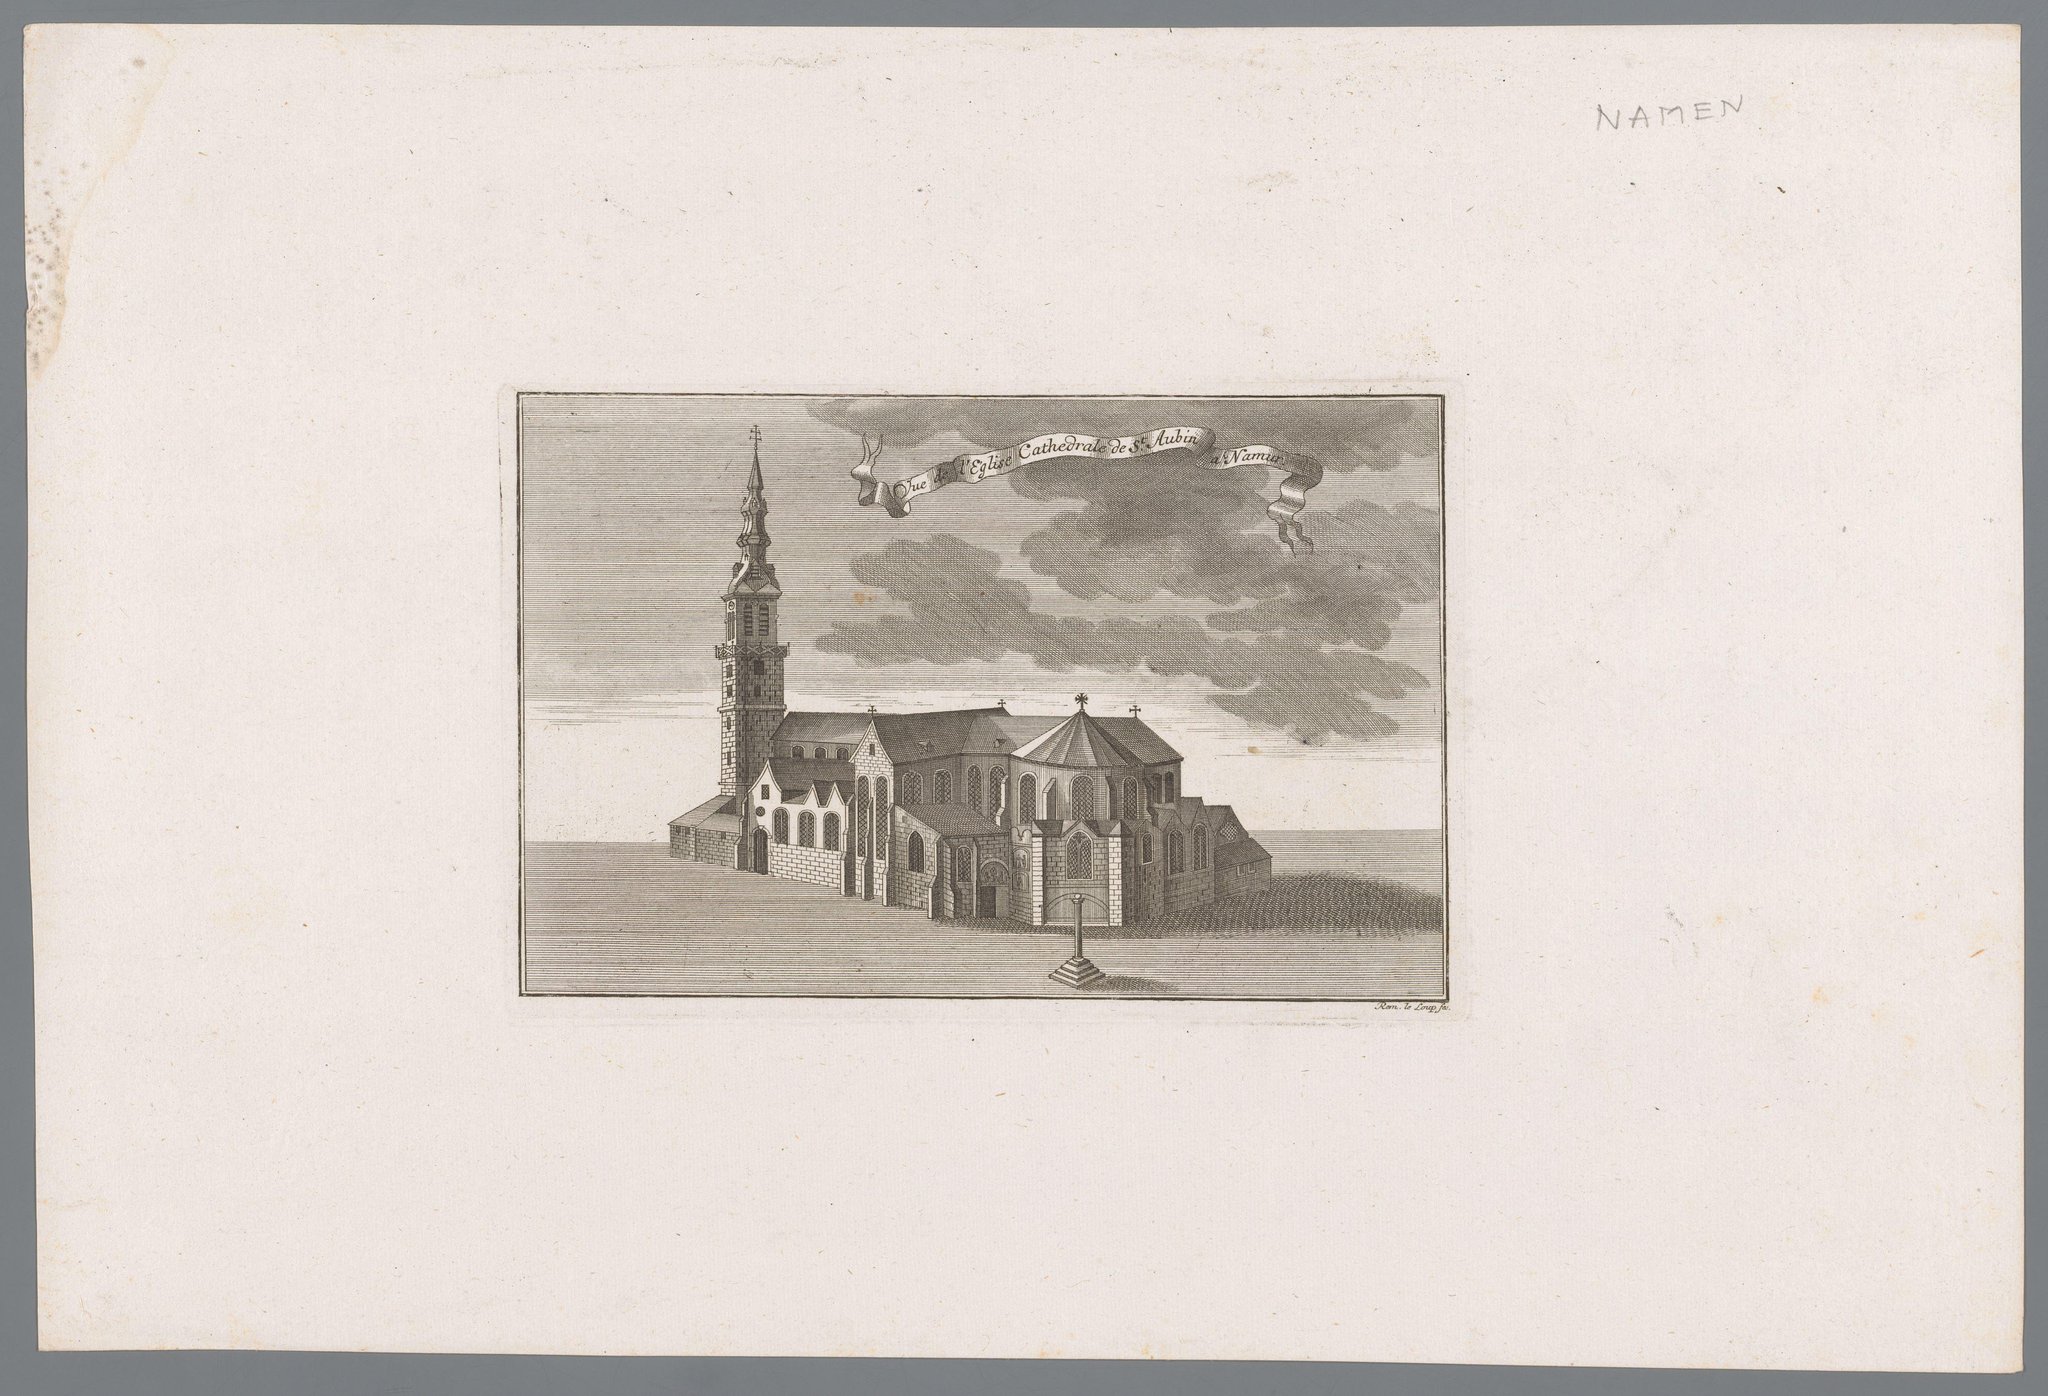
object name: book illustration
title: Gezicht op de Sint-Albanuskathedraal in Namen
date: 1738-1744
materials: paper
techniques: engraving, etching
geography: liège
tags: church (exterior)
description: Prent uit: Johanne de Saumery, Alexandre de et al. Les délices du païs de Liège, ou description géographique, topographique et chorographique des monumes sacrés et profanes (...). 5 dln. Luik: Everard Kints, 1738-1744, dl. 2, p. 154.